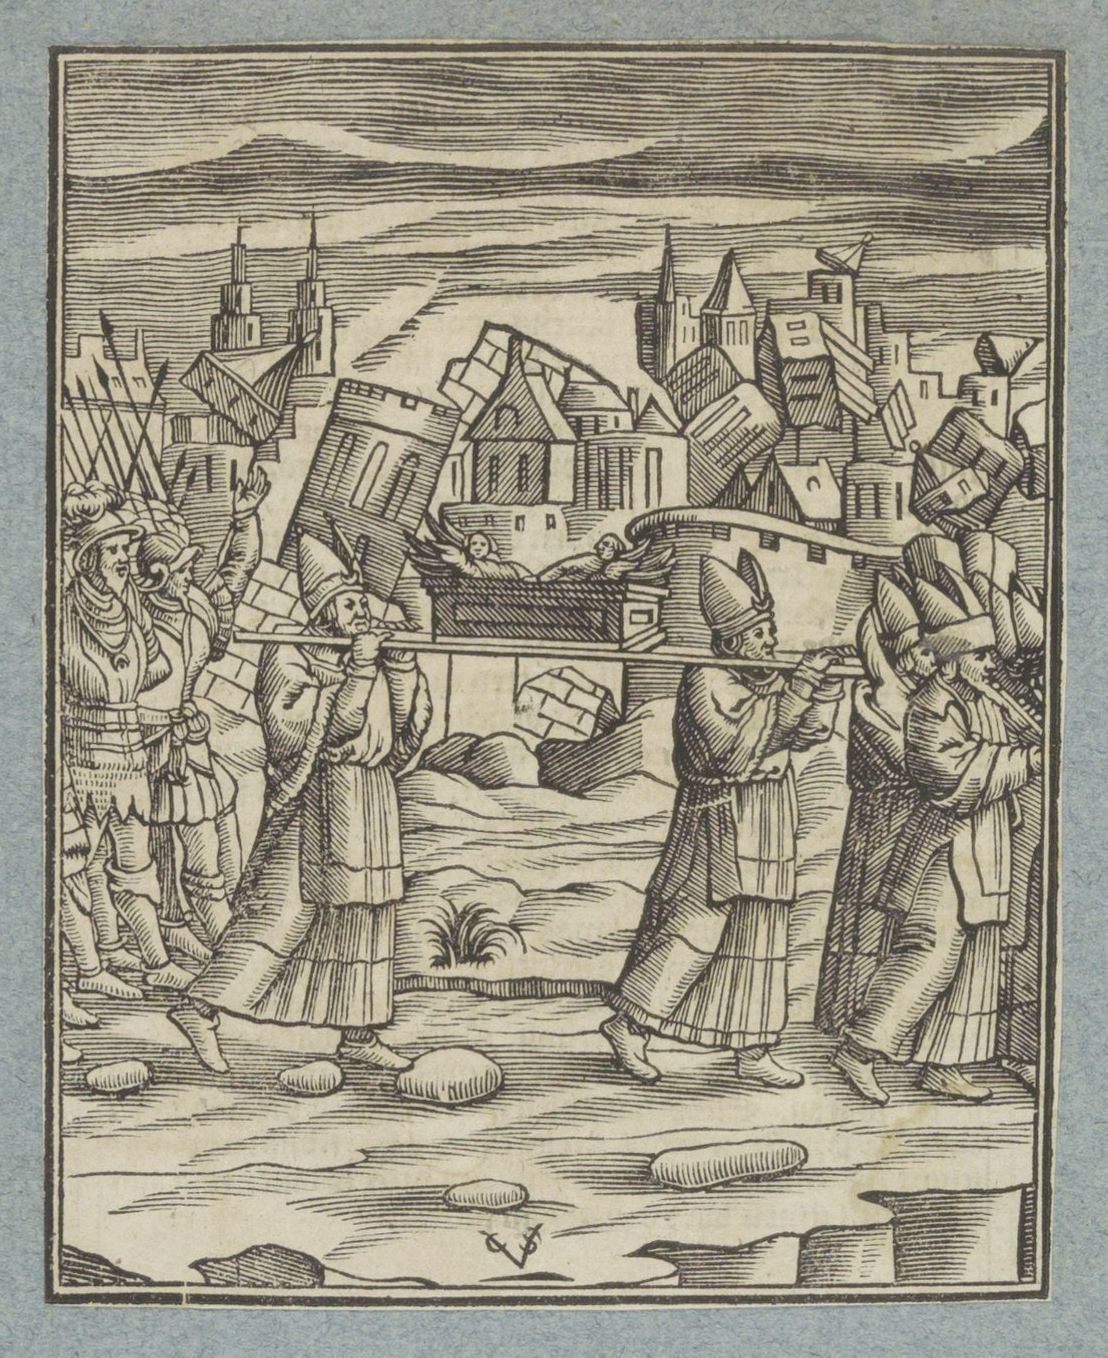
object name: album leaf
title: Val van Jericho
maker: pieter jacobsz. paets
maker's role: publisher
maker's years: 1587-1667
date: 1645-1646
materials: paper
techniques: letterpress printing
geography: amsterdam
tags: the israelites march around jericho: in the procession the main body of the soldiers comes first, next are seven priests who blow on trumpets, followed by the priests carrying the ark and a rear guard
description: De prent werd gemaakt voor de uitgaven van P.J. Paets uit Amsterdam. Ze komt in ieder geval voor in: Bibels Tresoor ofte der zielen lusthof. Amsterdam, P.J. Paets, 1646. Mogelijk ook in: Historien ende Prophetien. [Amsterdam], P.J. Paets, 1645.